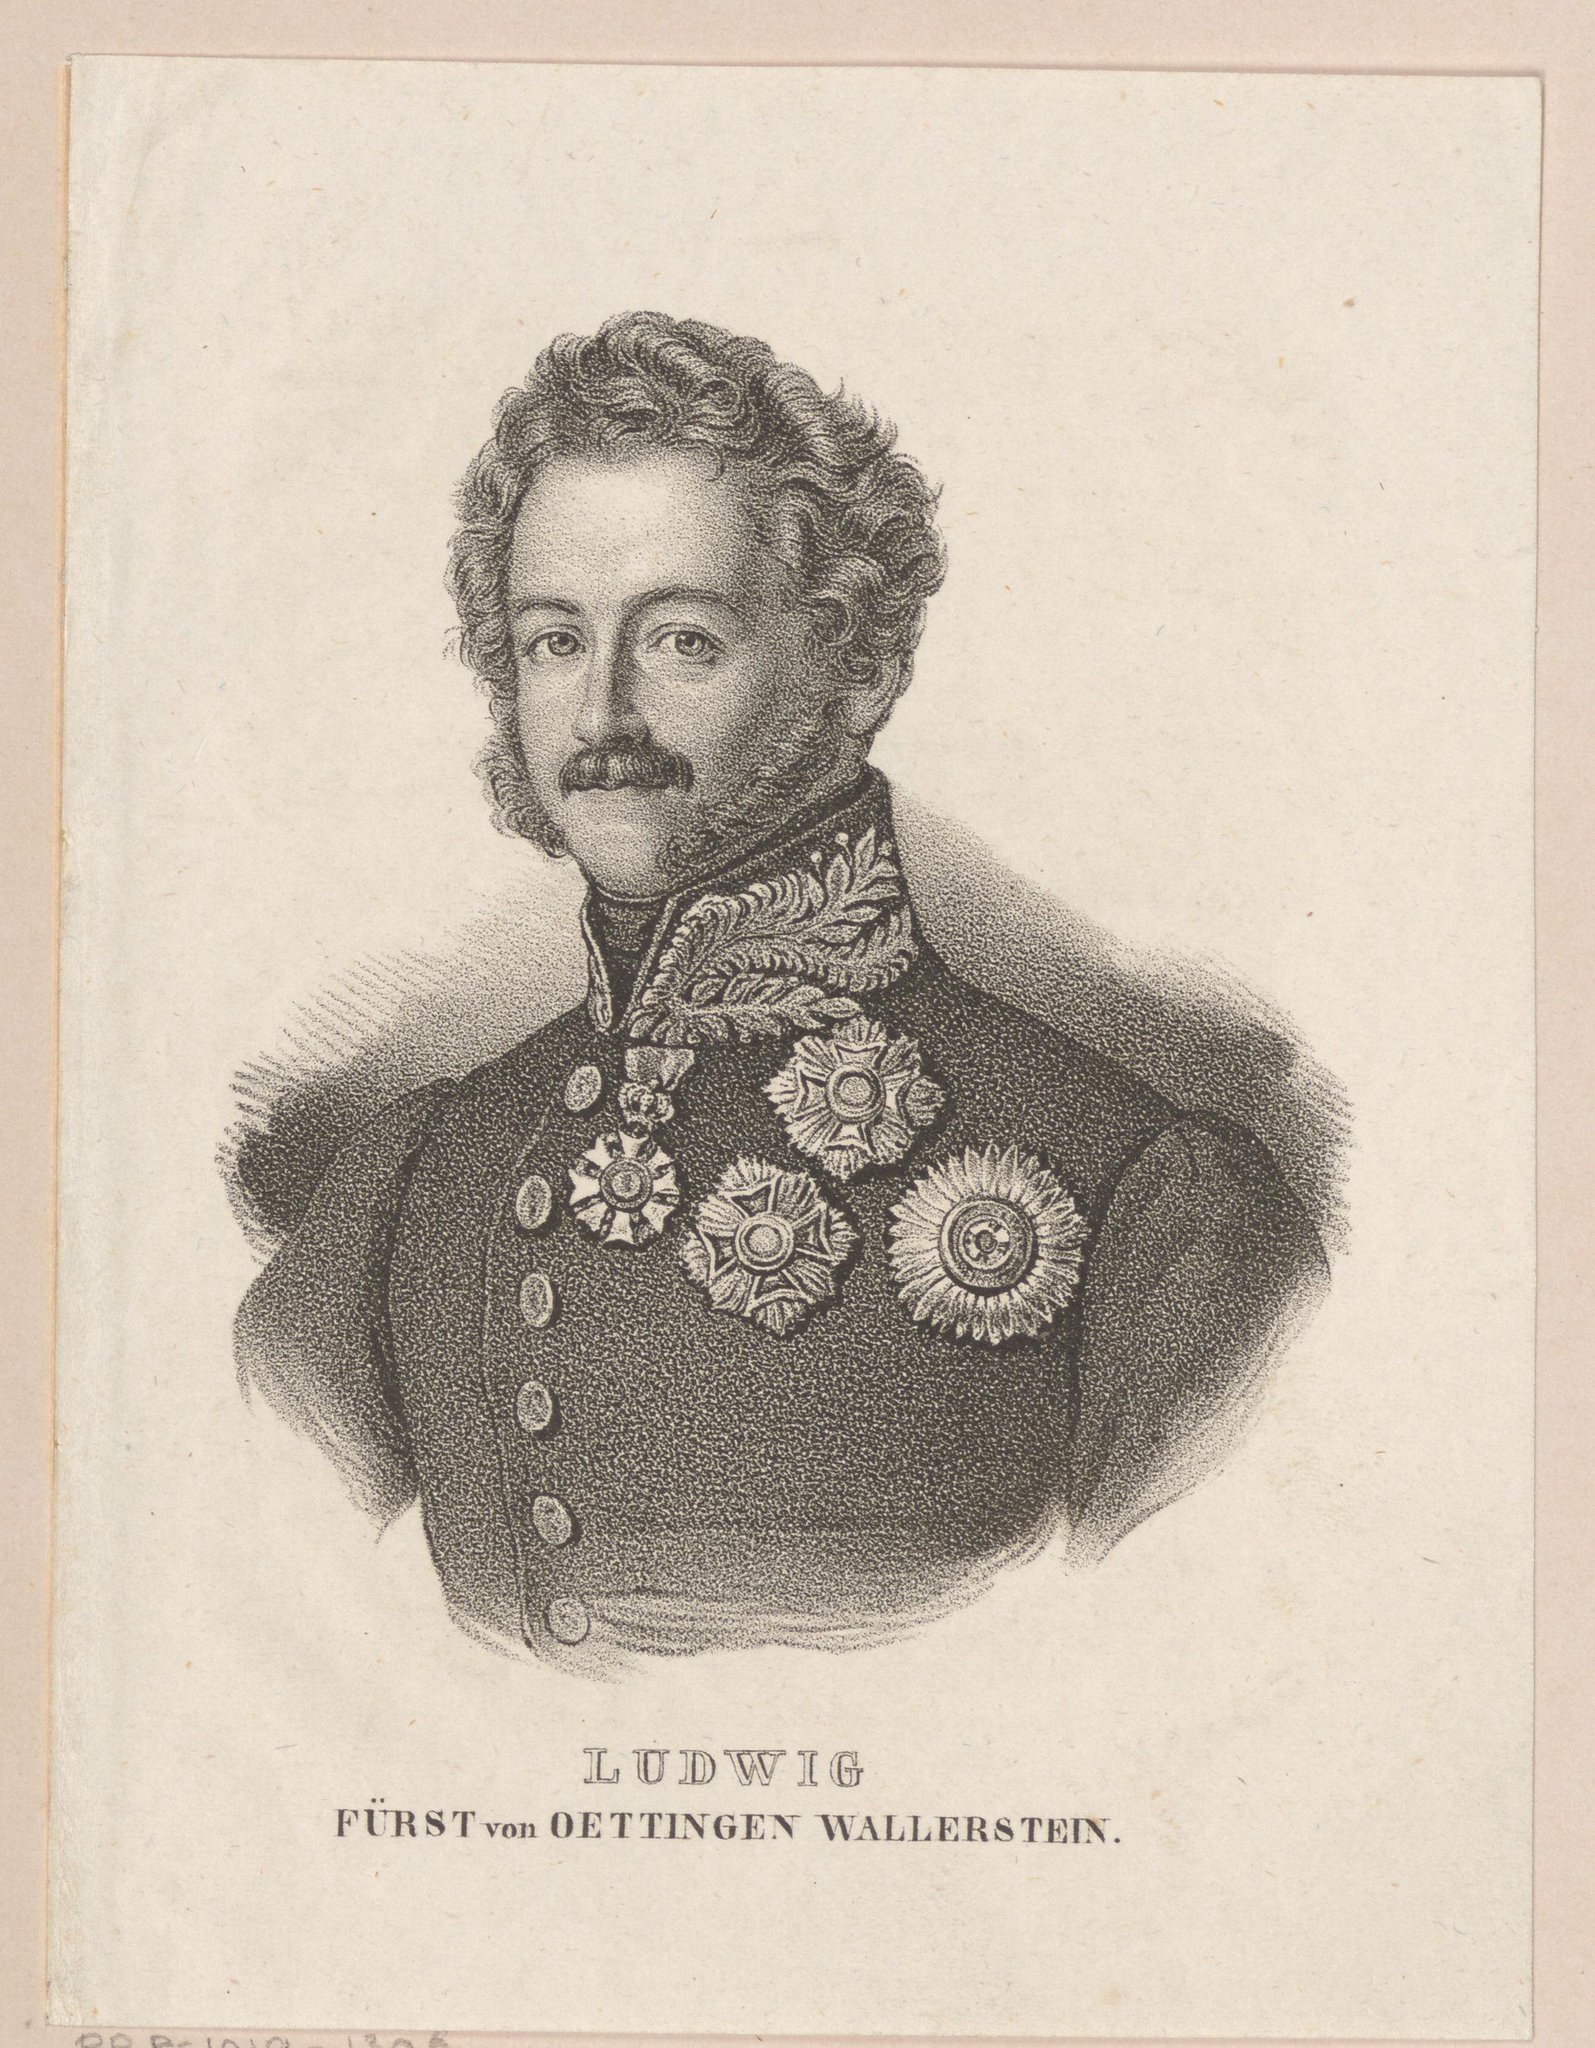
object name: print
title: Portret van Ludwig Fürst von Oettingen-Wallerstein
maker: Anonymous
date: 1802-1899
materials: paper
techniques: lithograph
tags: historical persons, medals and other marks of military honour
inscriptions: collector's mark: Lugt 2228